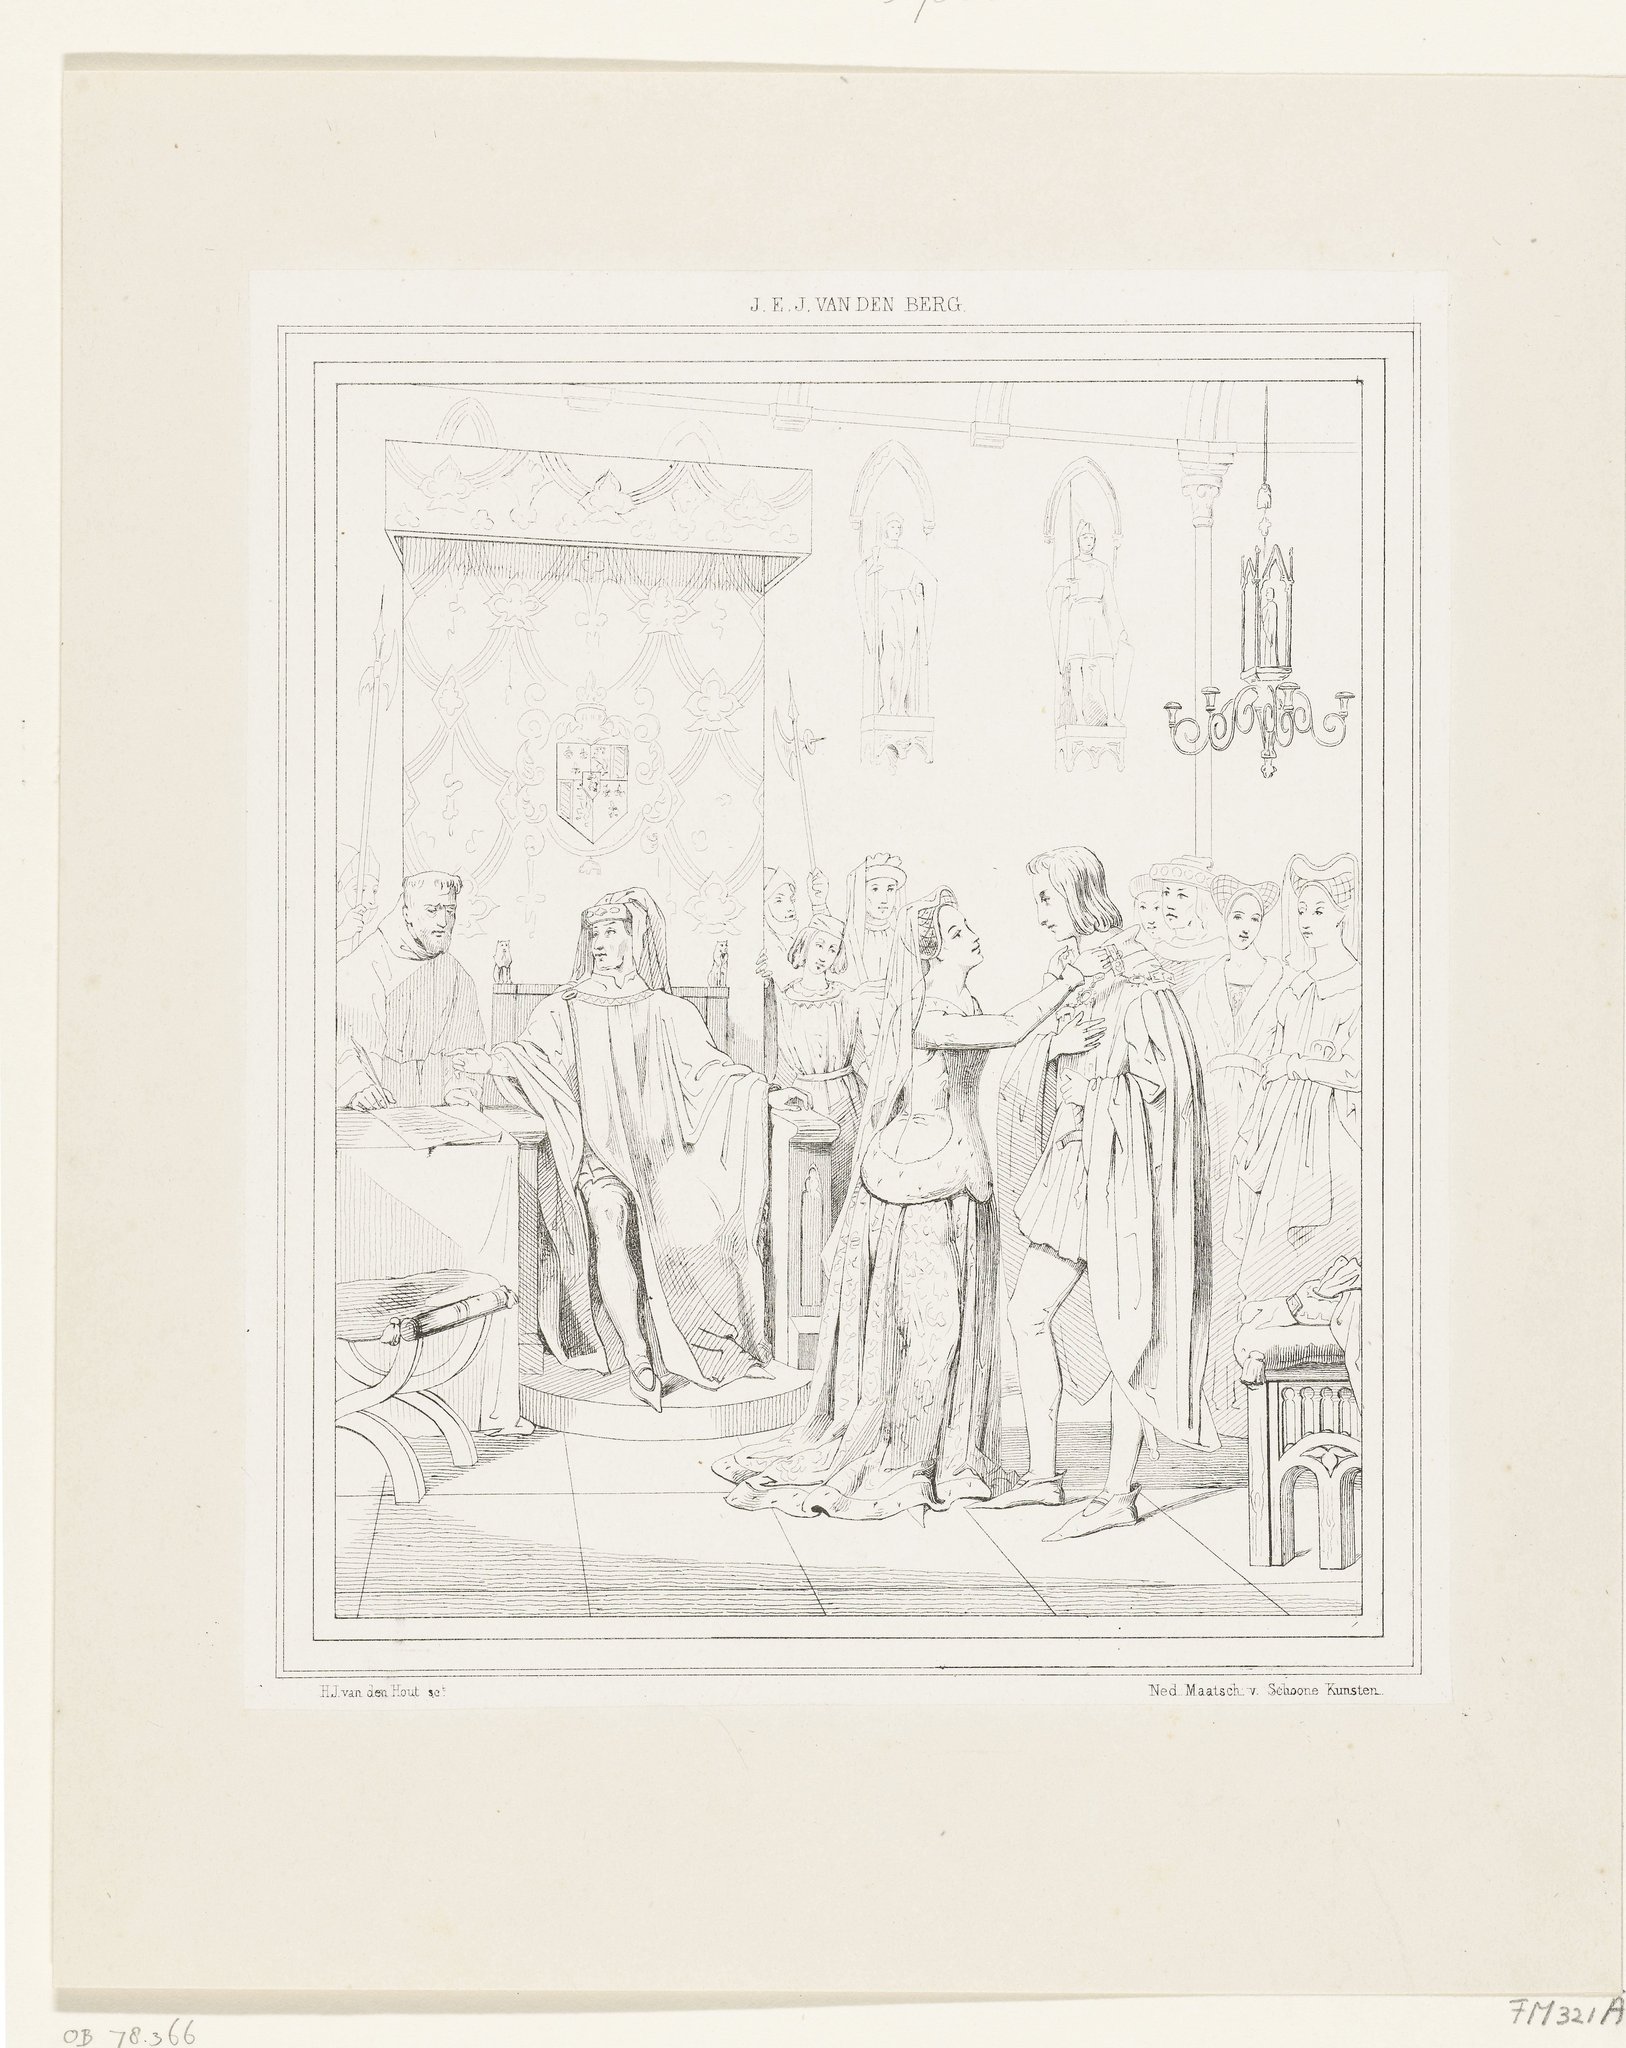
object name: history print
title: Maria van Bourgondië hangt de ketting met het Gulden Vlies om de hals van aartshertog Maximiliaan van Oostenrijk, 1477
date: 1840-1843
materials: paper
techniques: lithograph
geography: netherlands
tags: brussels, bruges, maria (hertogin van bourgondië), maximilian i (holy roman emperor), knighthood order of the golden fleece, burgundian netherlands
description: Maria van Bourgondië hangt de ketting met het Gulden Vlies om de hals van aartshertog Maximiliaan van Oostenrijk, 1477.